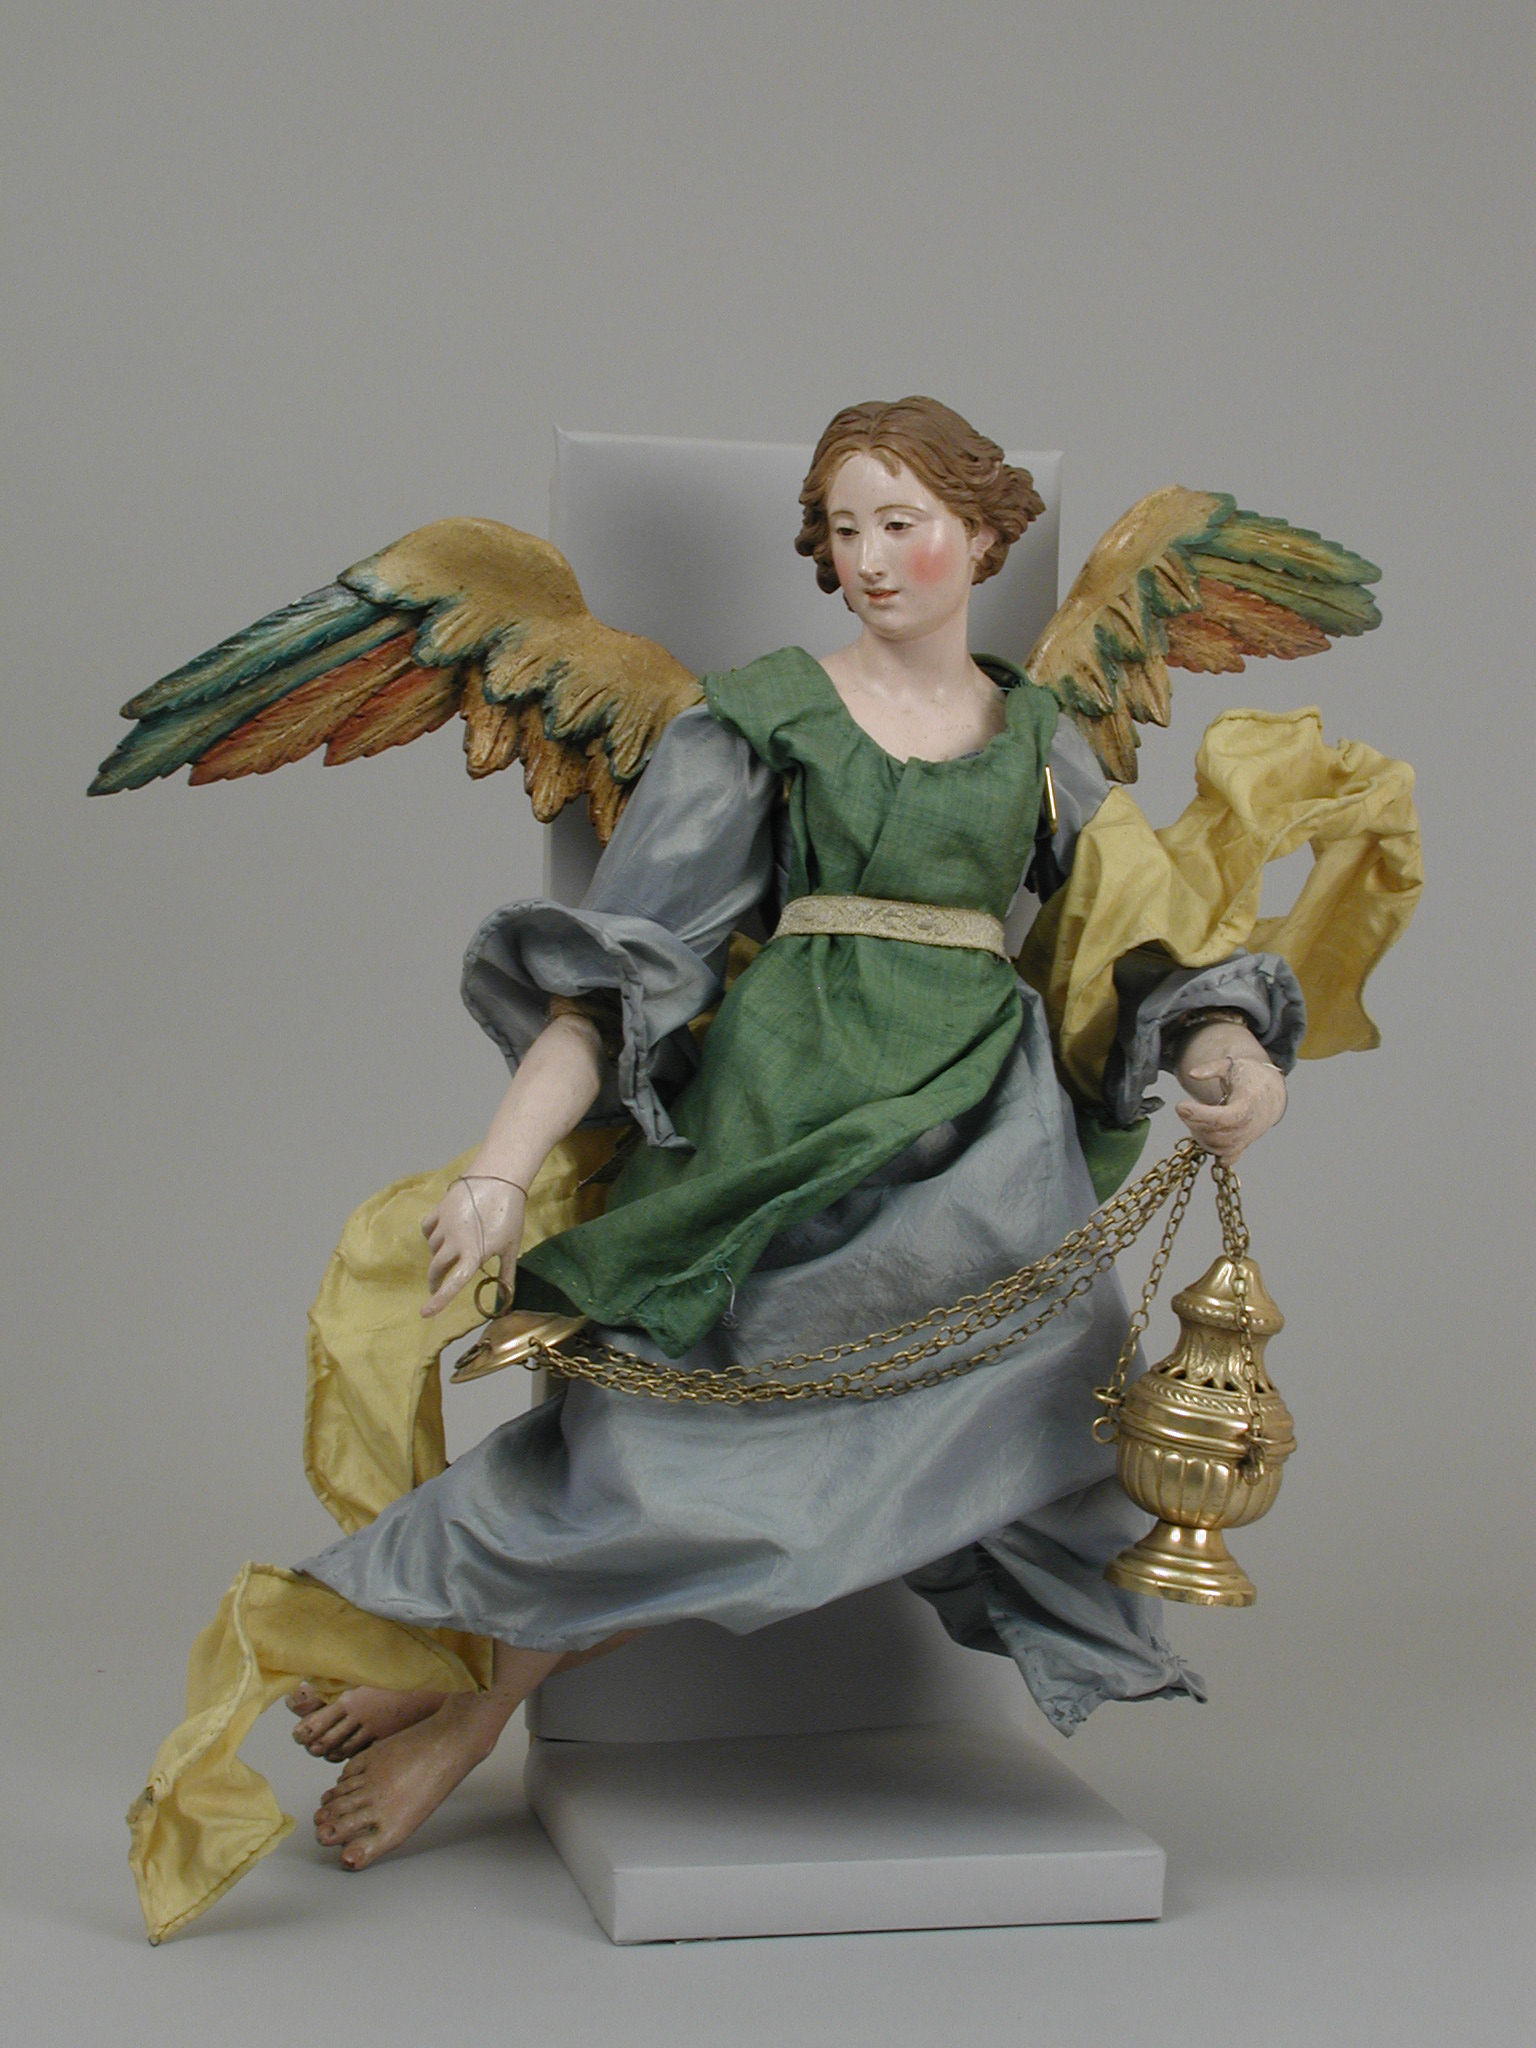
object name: crèche figure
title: Angel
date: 1701-1900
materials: silver gilt, fiber, terracotta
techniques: polychrome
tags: angels